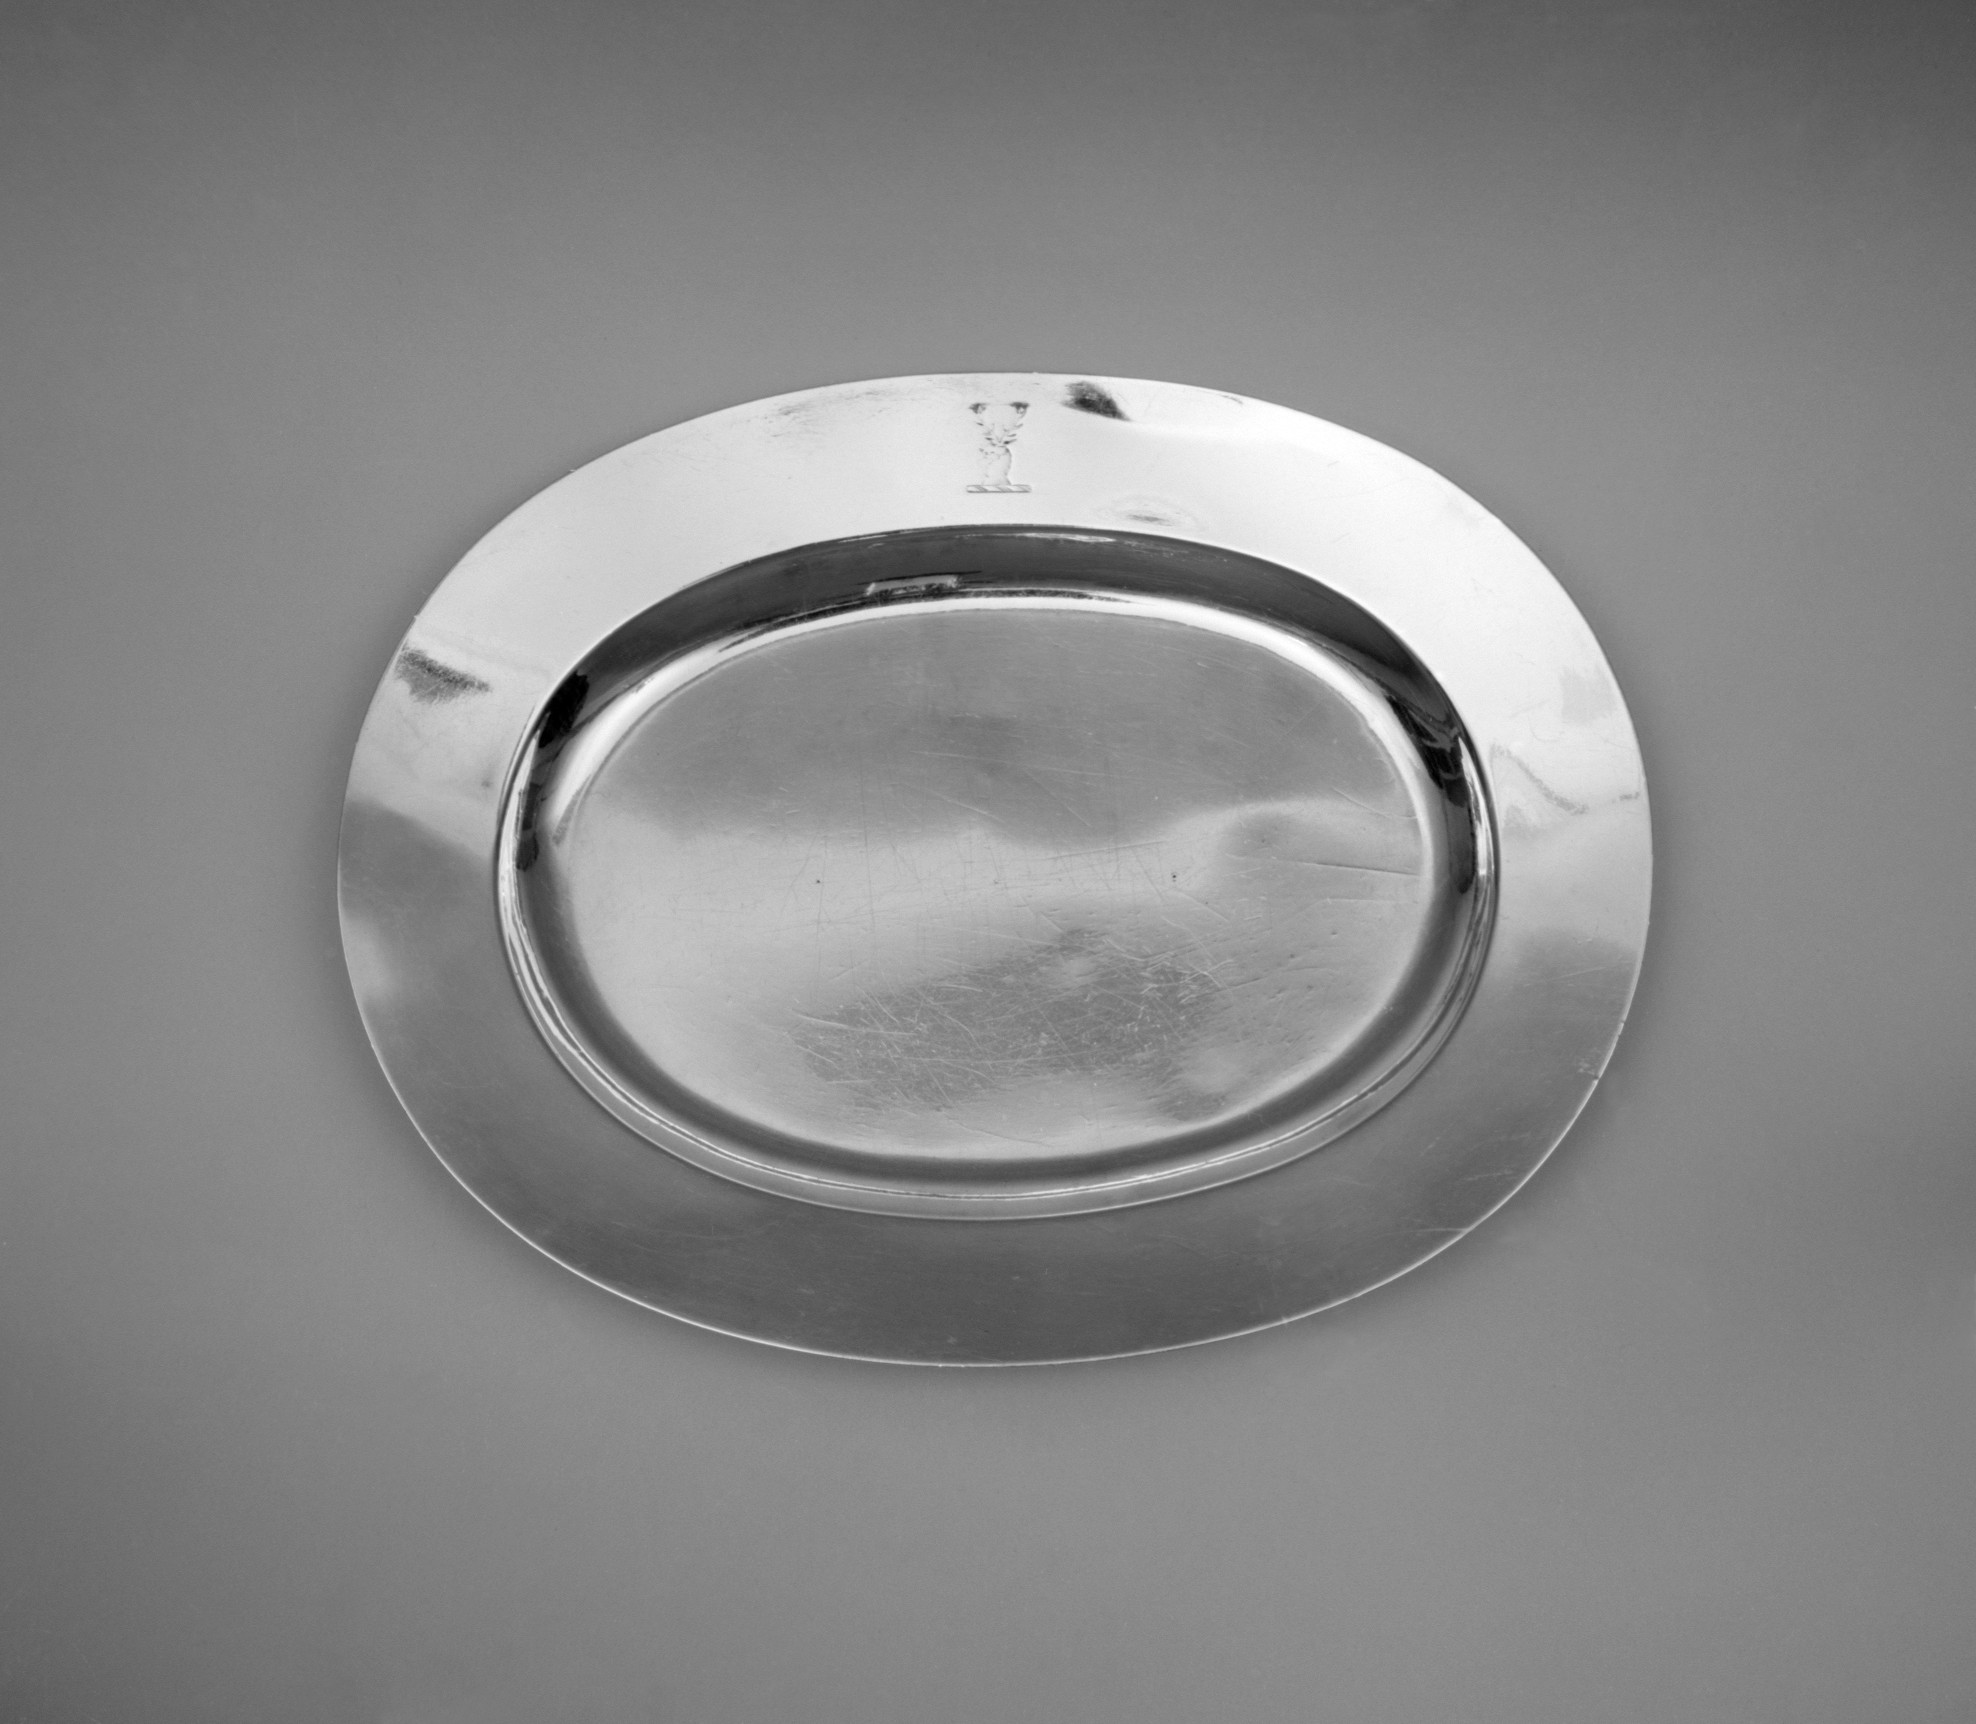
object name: dish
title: Oval dish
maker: pierre platel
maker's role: maker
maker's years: 1699-1719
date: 1702-1703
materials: silver